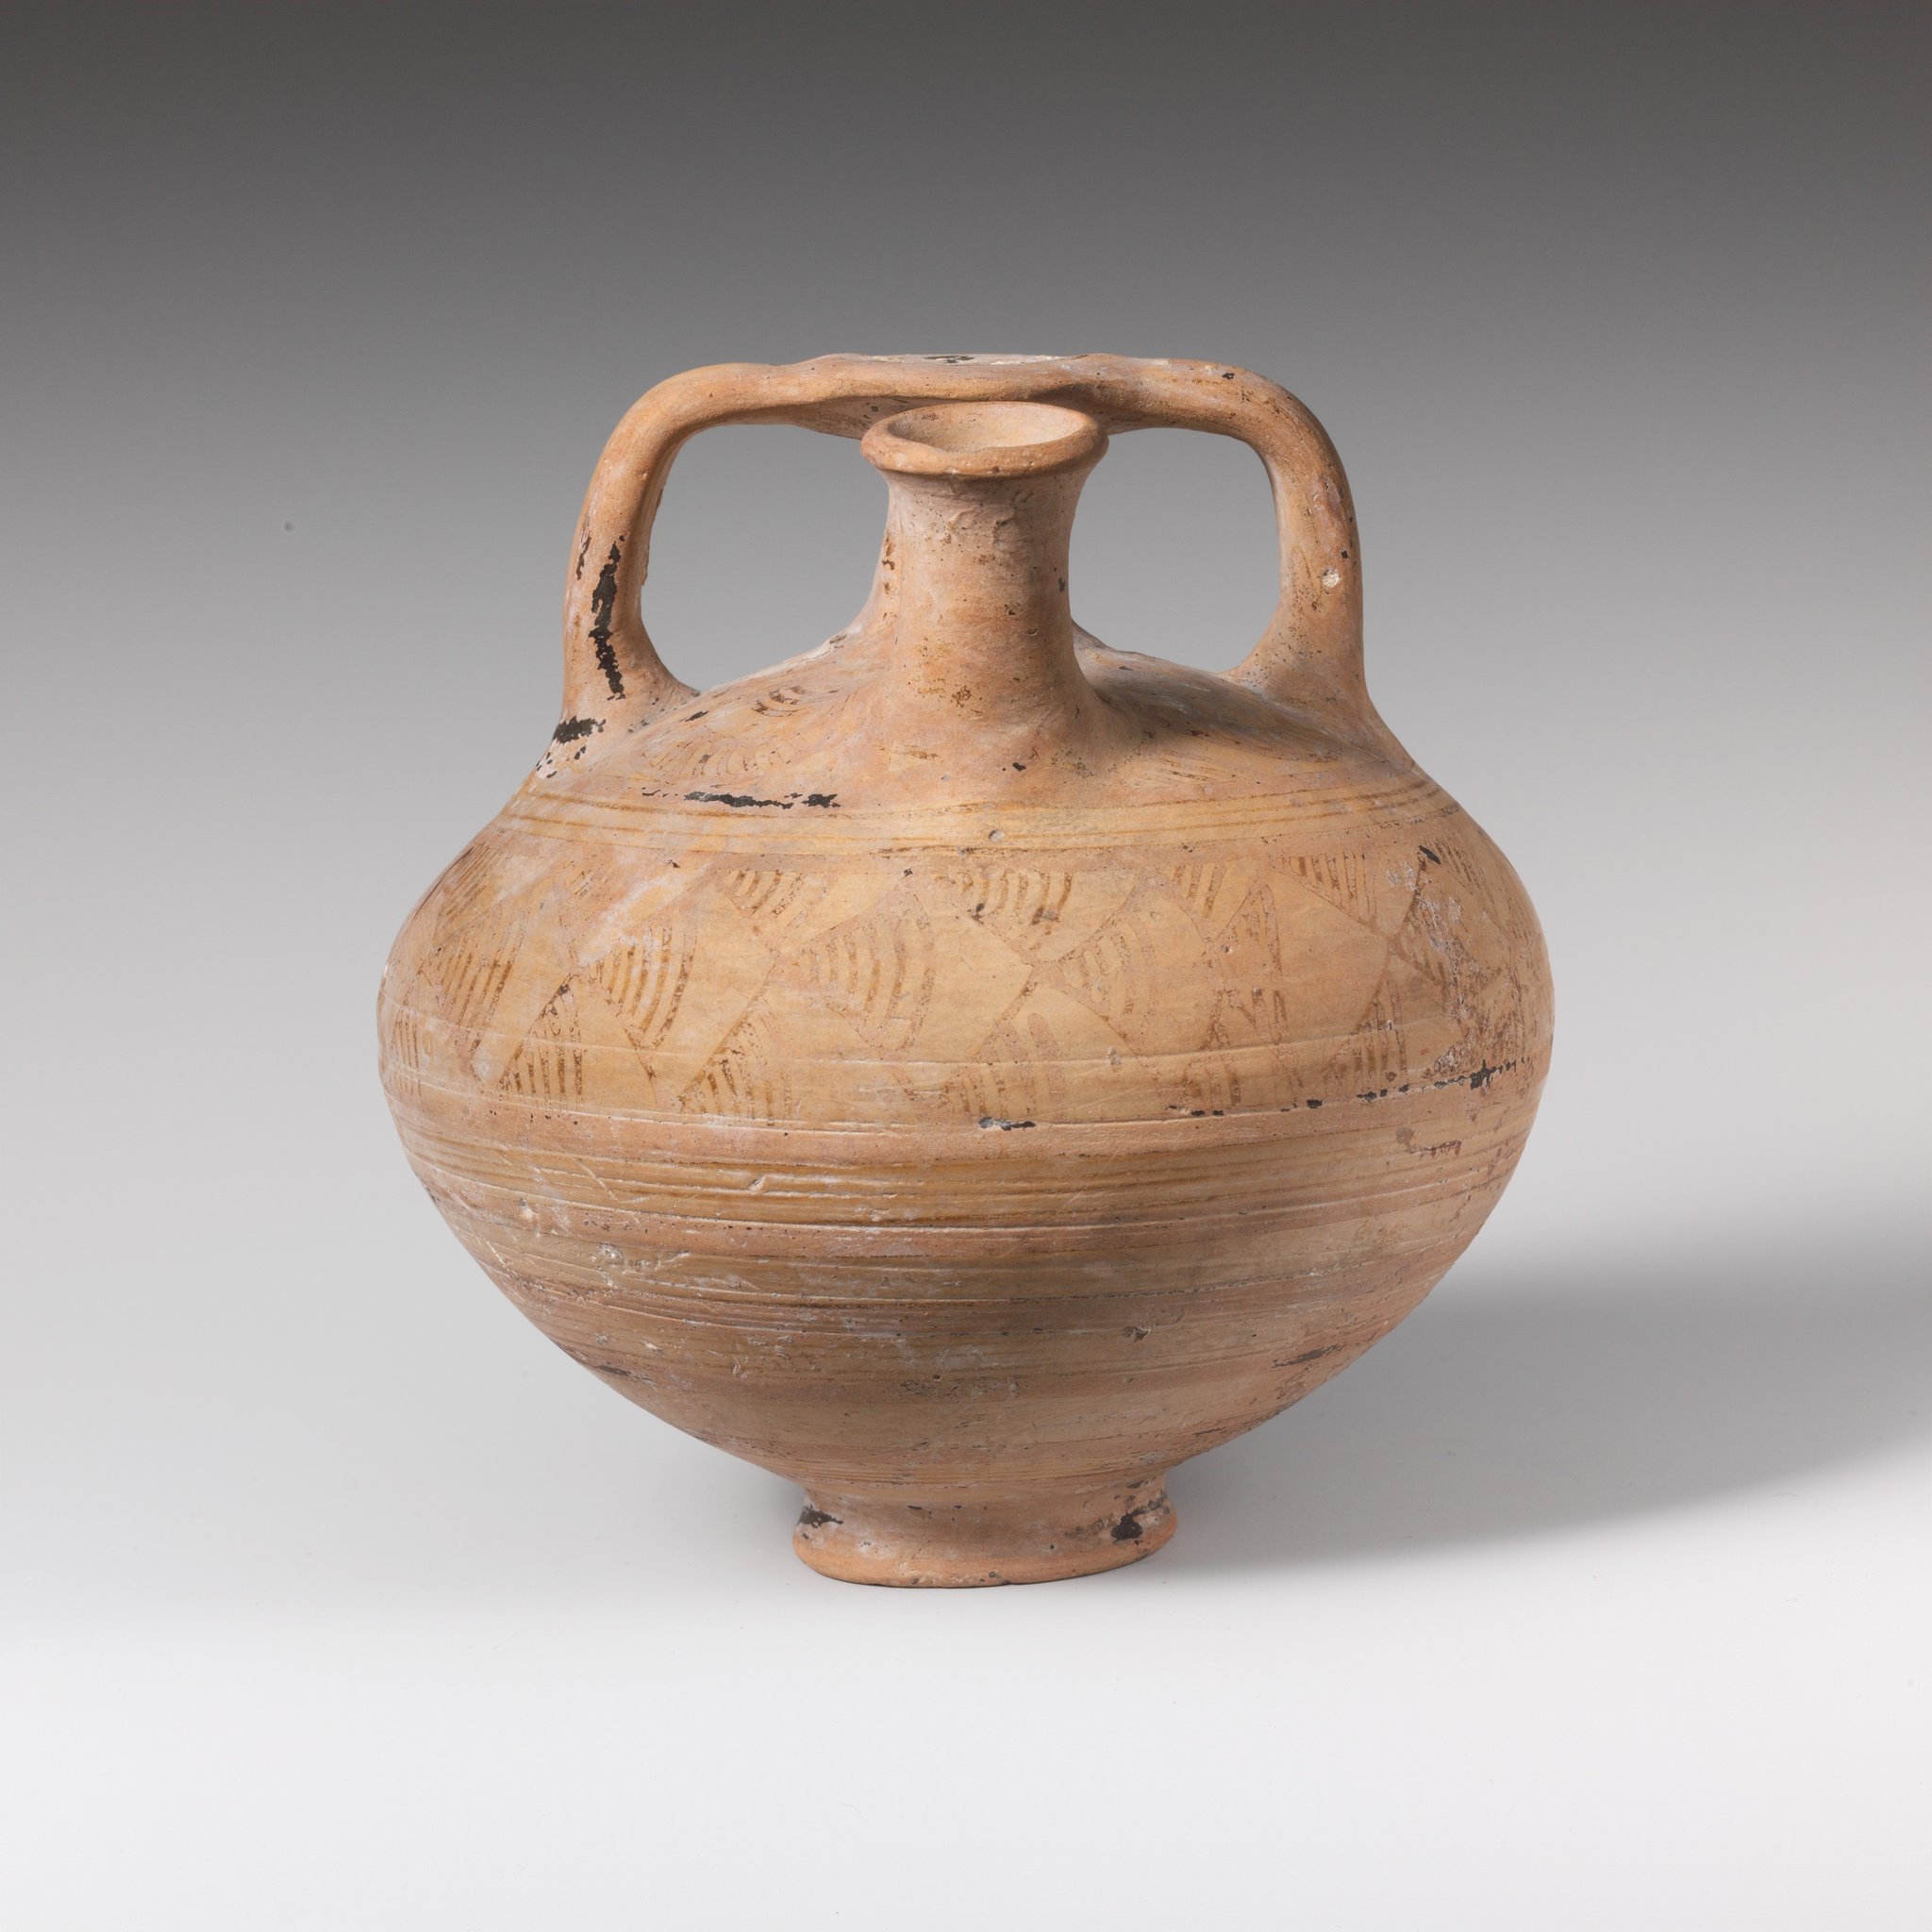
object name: stirrup jar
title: Terracotta stirrup jar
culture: mycenaean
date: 1400-1050 BCE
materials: terracotta